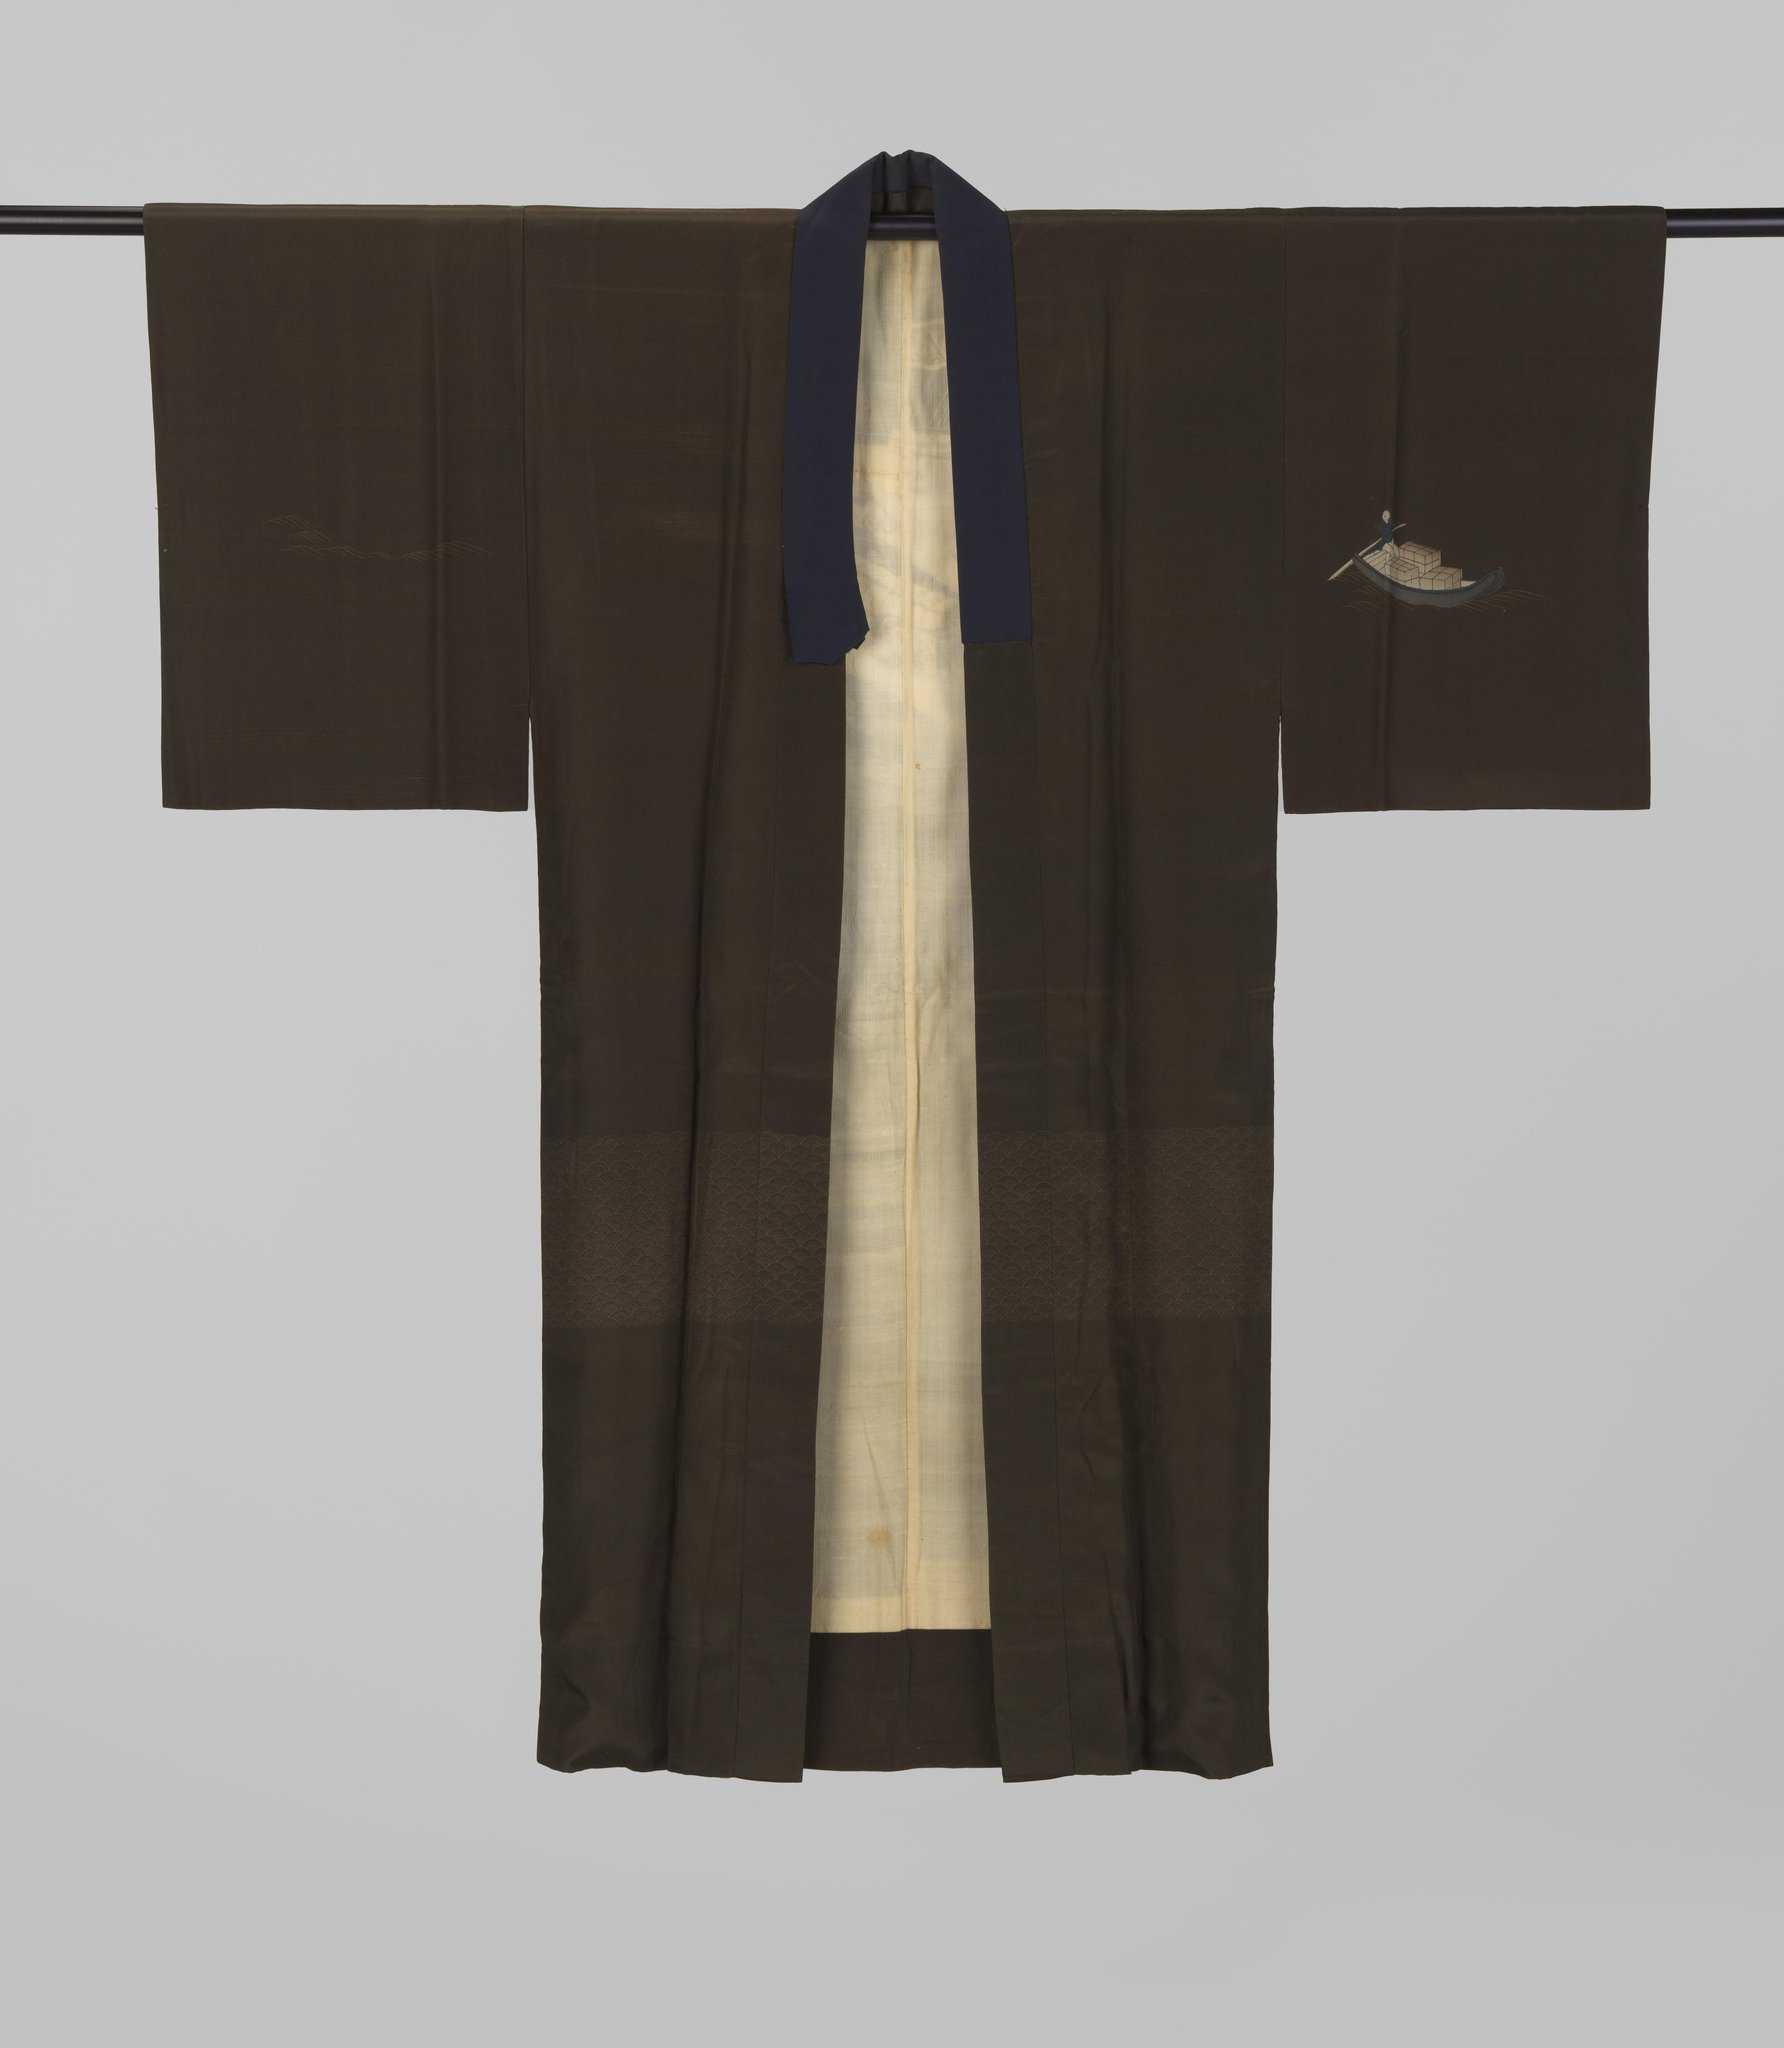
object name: kimono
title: Mannen nagajuban met Europees schip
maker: Anonymous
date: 1920-1940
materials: silk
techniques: weave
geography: japan